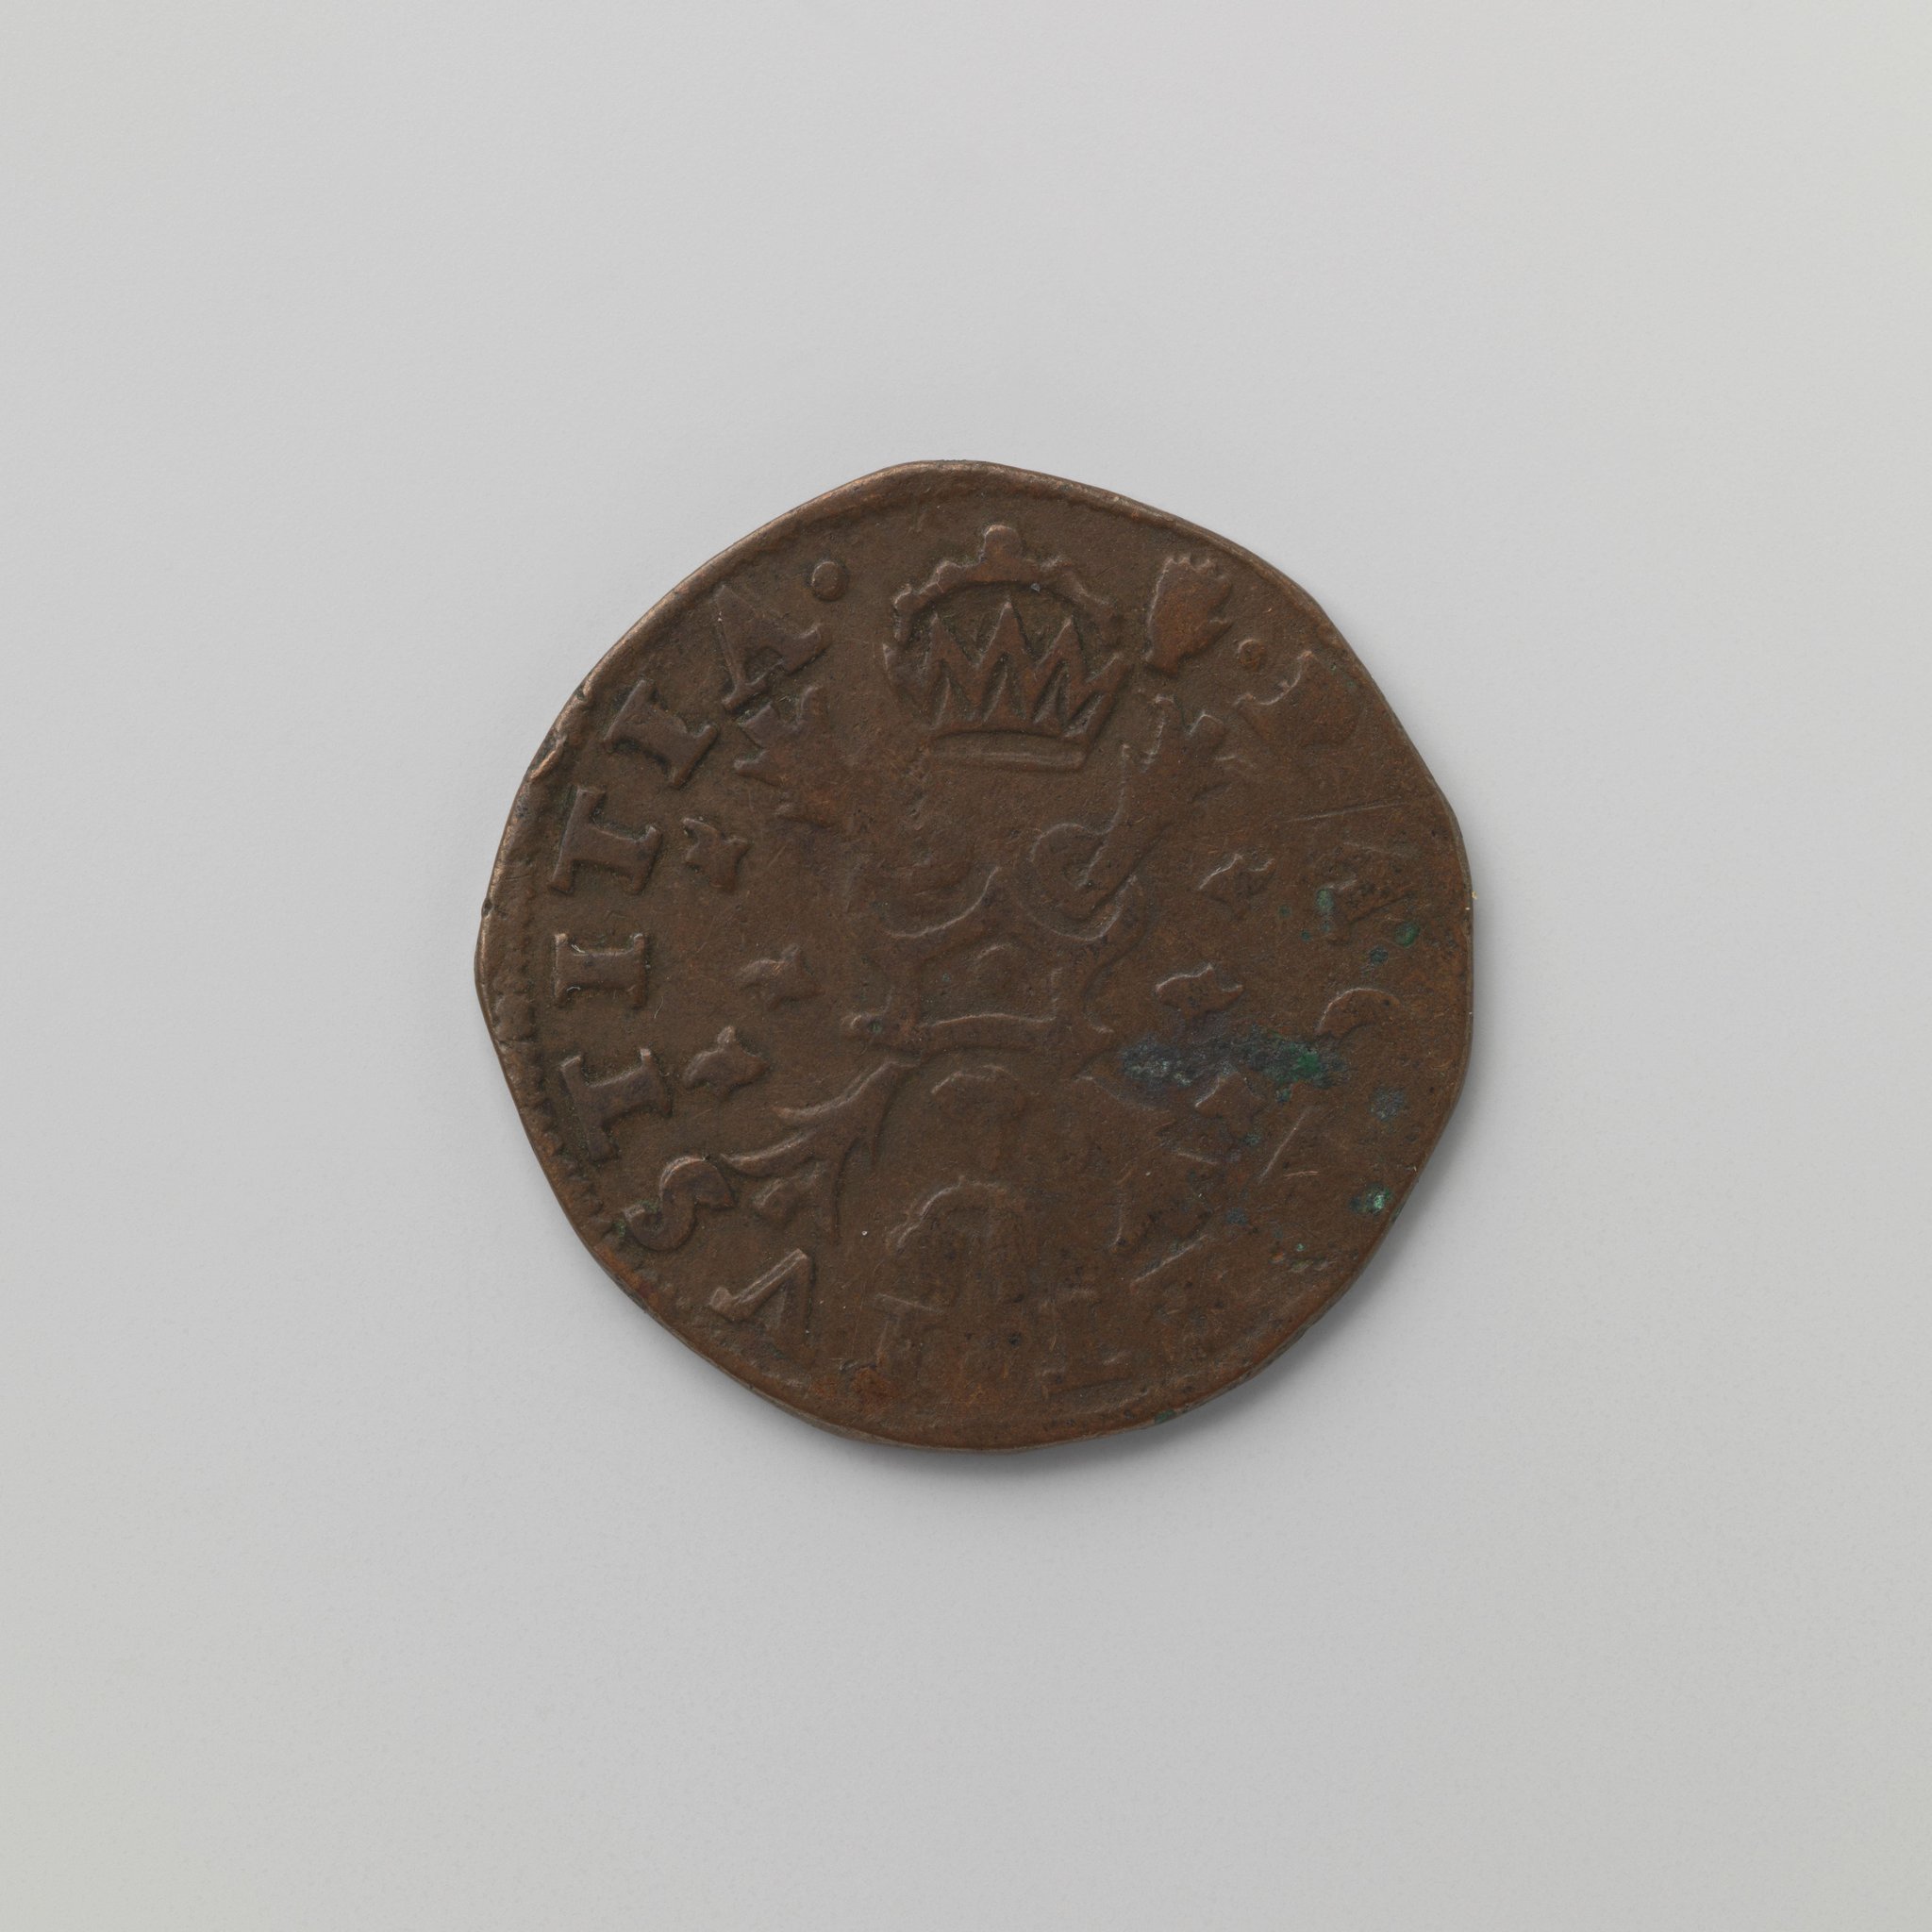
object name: coin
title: Staten van Brabantop naam van Philips II, statenduit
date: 1577-1578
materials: copper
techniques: striking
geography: antwerp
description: Koperen munt. Voorzijde: gekroond versierd samengesteld wapenschild. Keerzijde: vuurijzer op stokkenkruis Daarboven kroon, daaronder gulden vlies. Hand aan het begin van het omschrift: PACE ET IVSTITIA